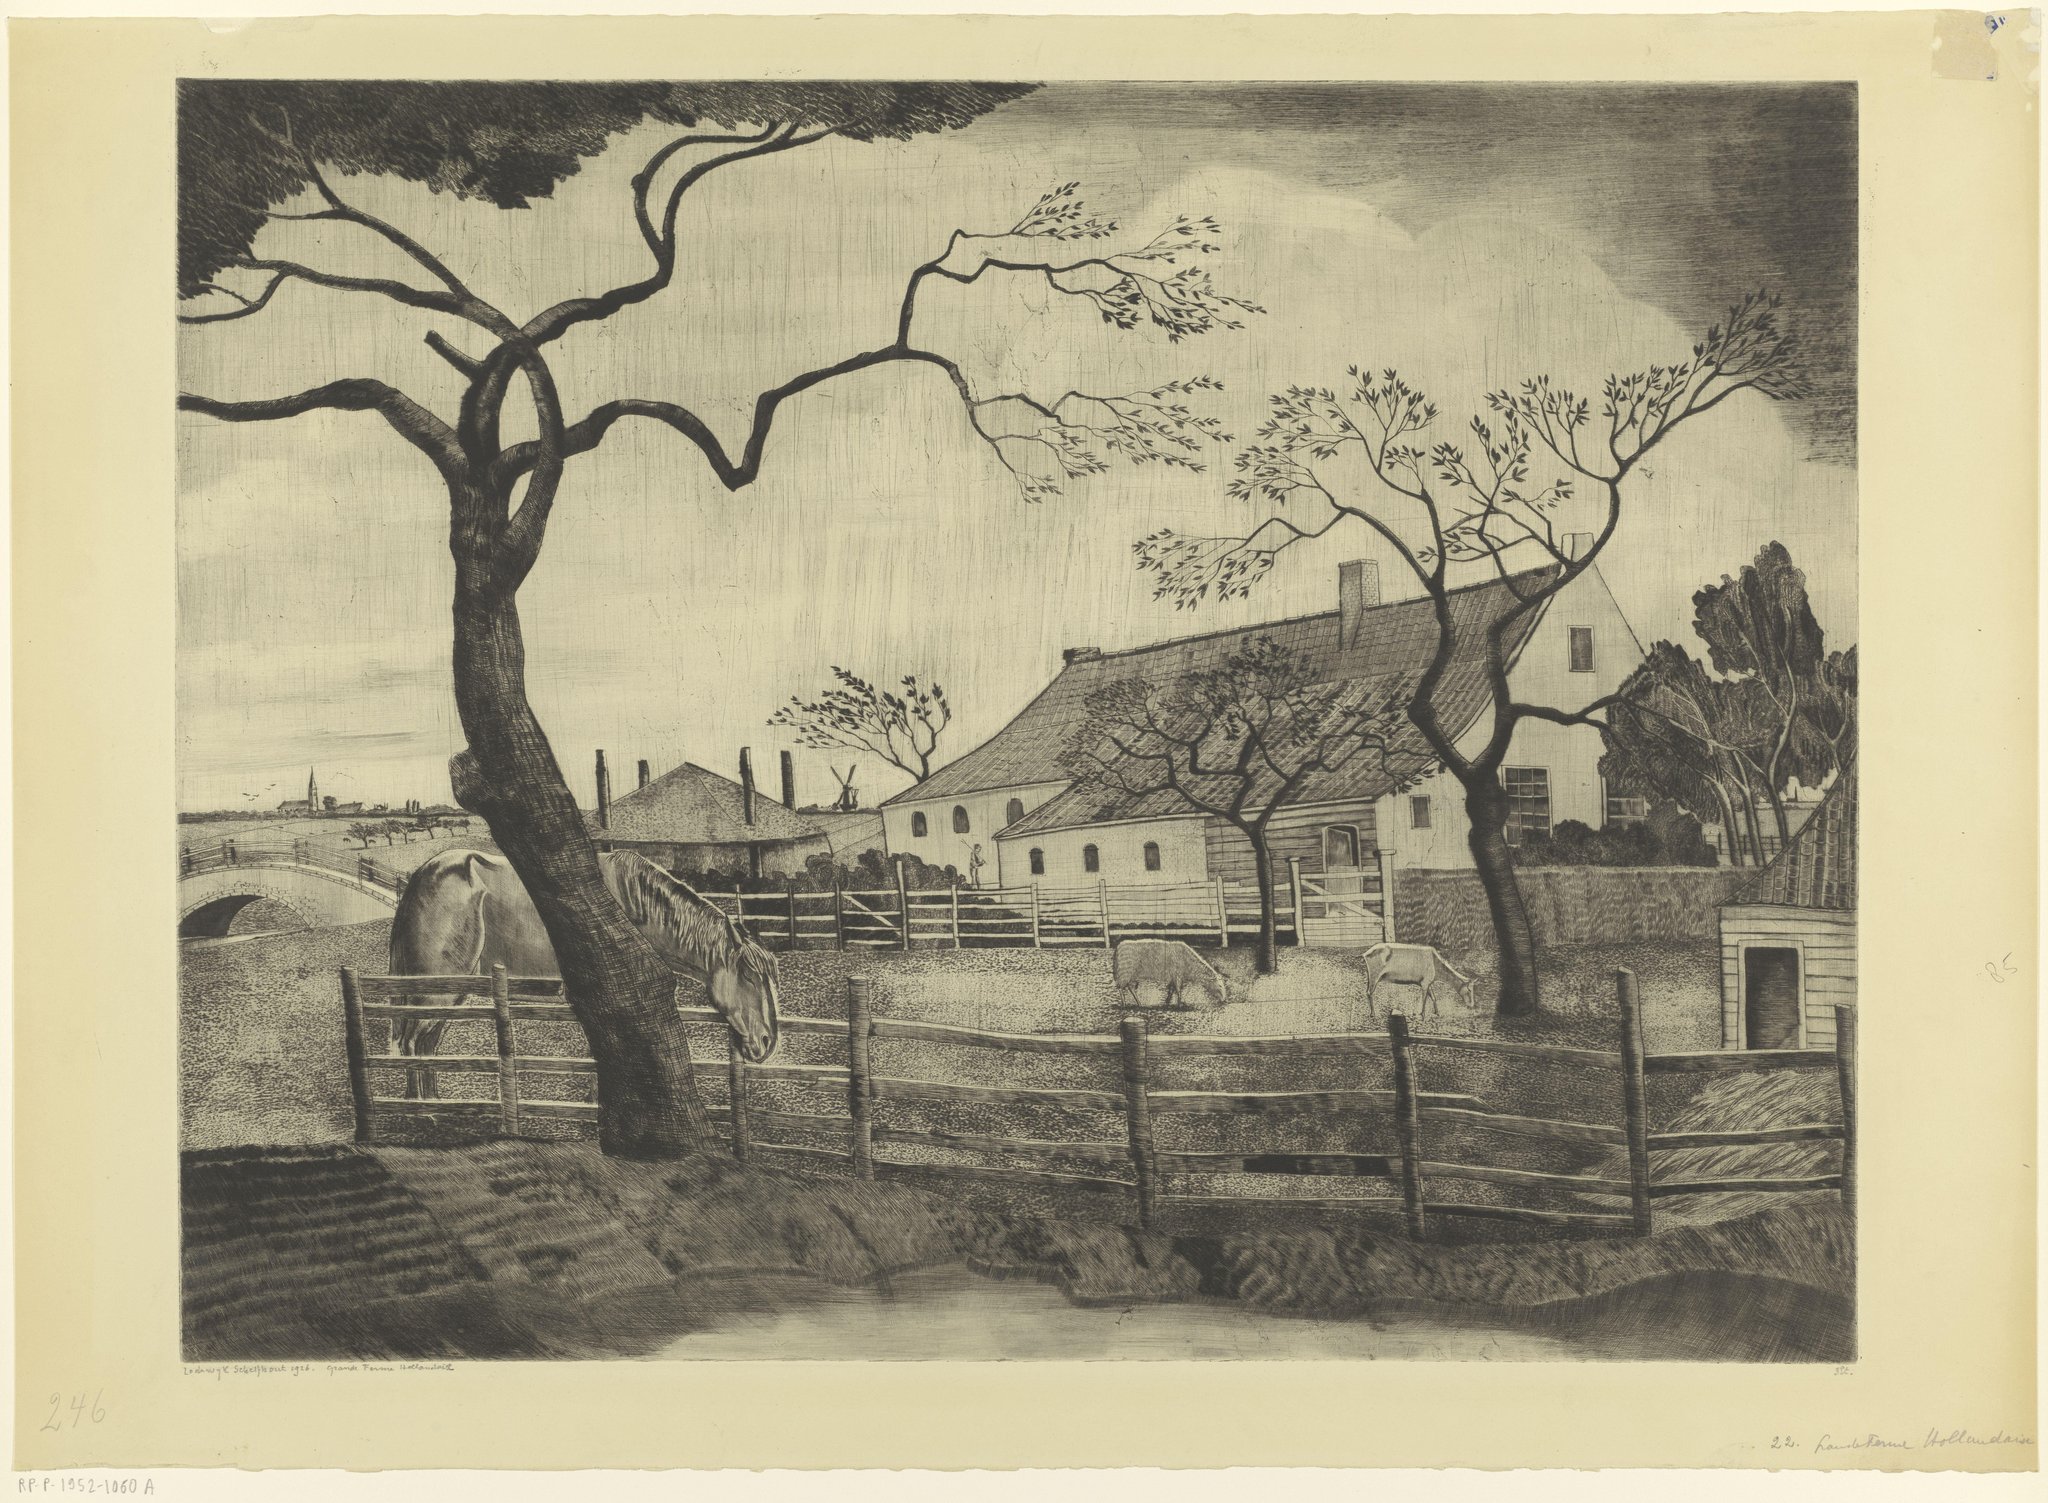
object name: print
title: Grande ferme Hollandais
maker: lodewijk schelfhout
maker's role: draughtsman, print maker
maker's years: 1881-1943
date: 1926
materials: paper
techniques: drypoint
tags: cattle, fence, wall, paling, farm or solitary house in landscape, holland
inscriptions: collector's mark: Lugt 2228, collector's mark: Lugt 5i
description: Op de voorgrond een door hekken begrensd weiland met een paard en twee schapen. Op de achtergrond een boerderij met een hooischuur en een brug.